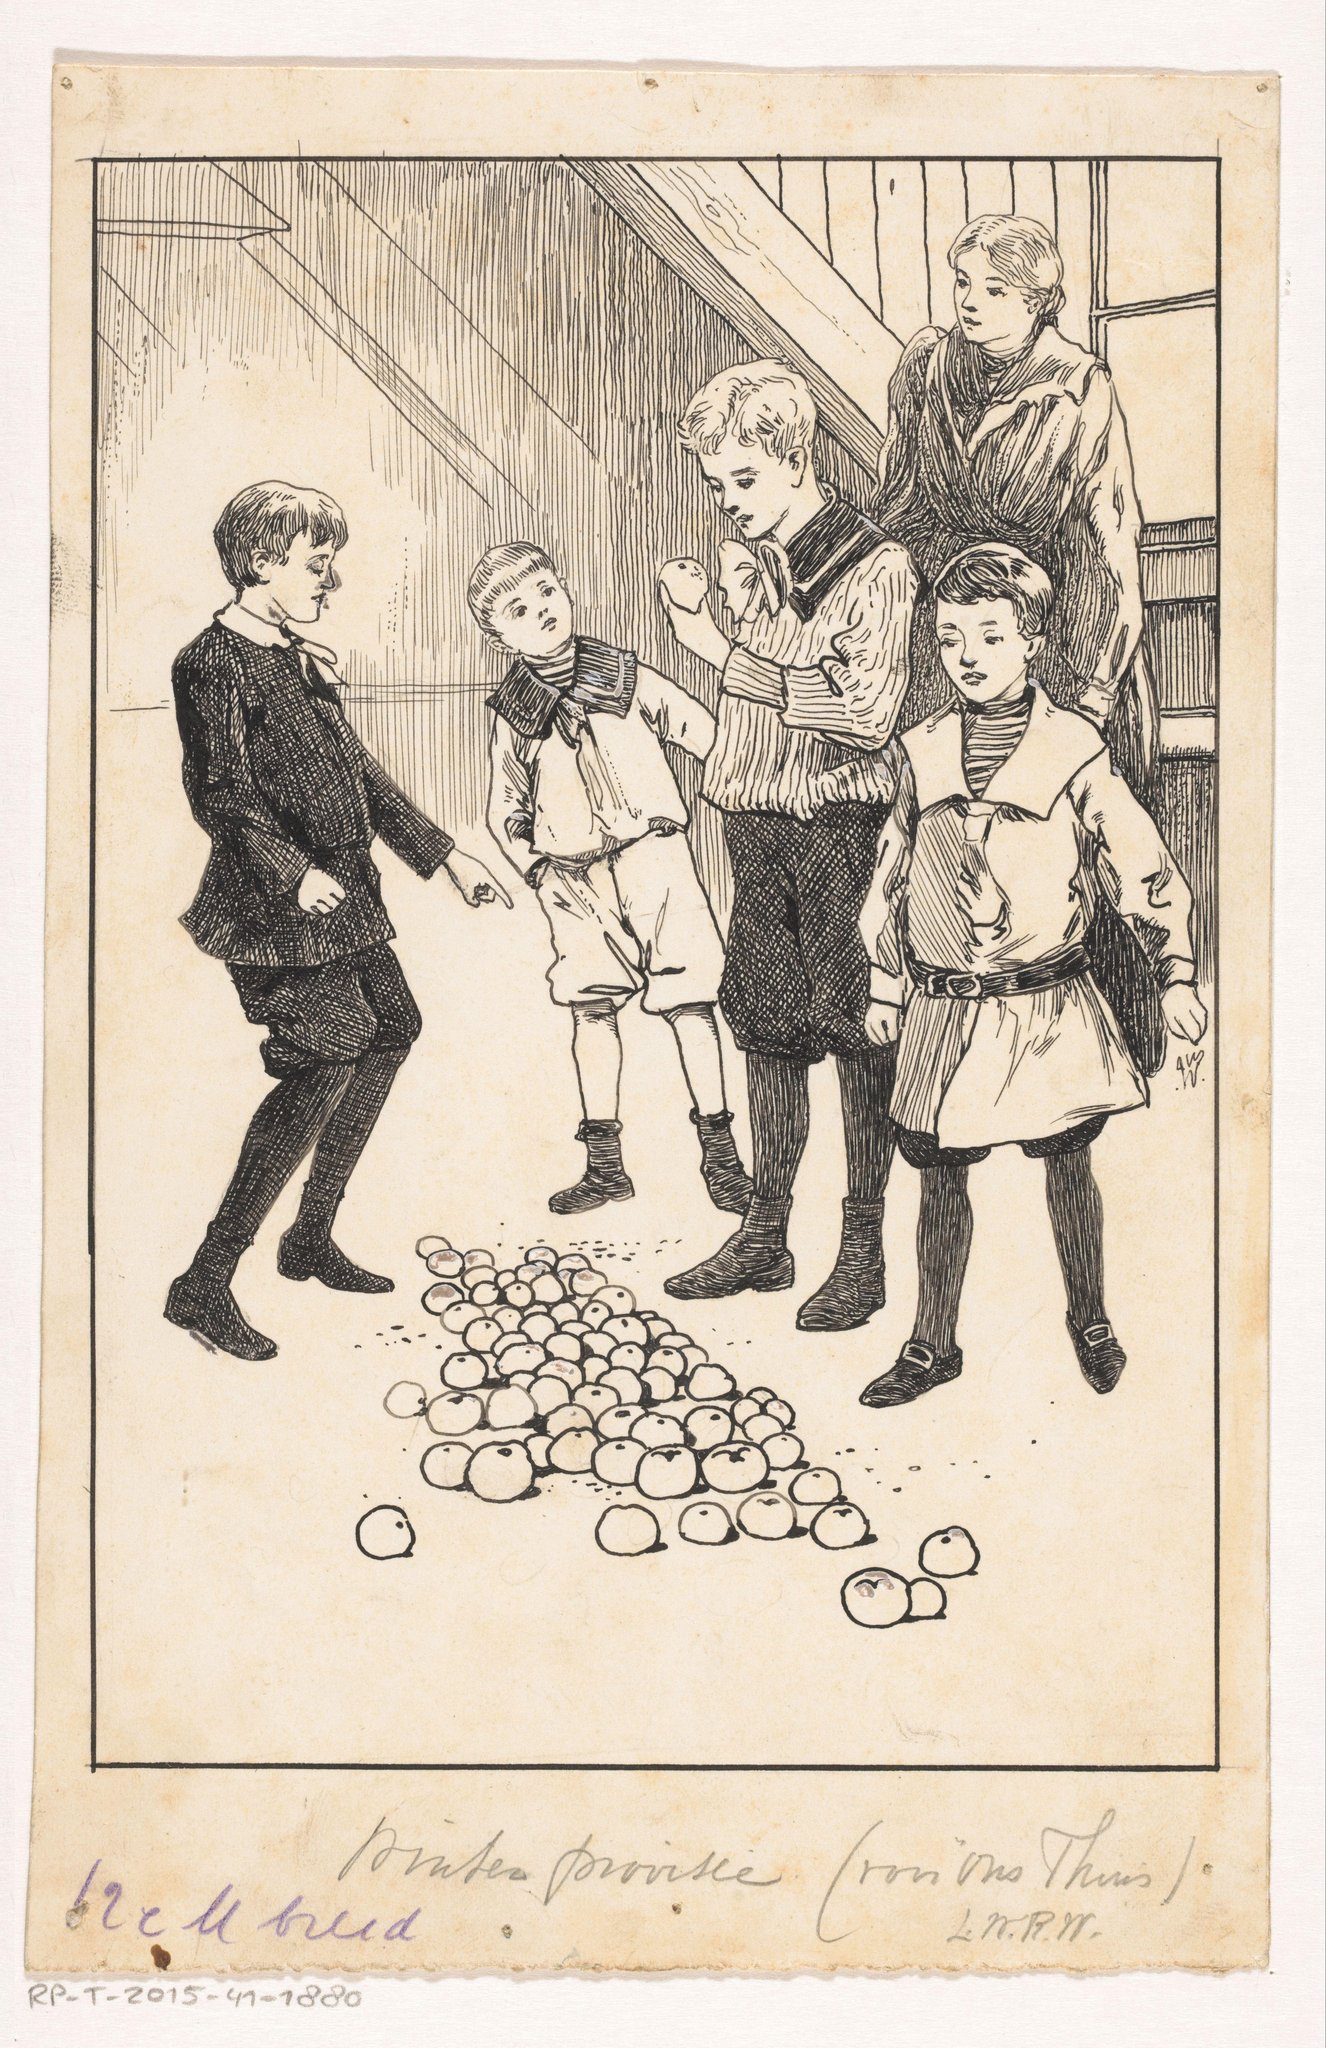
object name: drawing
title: Jongens bij een wintervoorraad appels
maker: willem wenckebach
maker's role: designer, draughtsman, painter, print maker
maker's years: 1860-1937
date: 1910-1937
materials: paint, ink, paper, pencil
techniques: brush, pen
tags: fruits: apple, boy (child between toddler and youth)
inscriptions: monogram:, collector's mark: Lugt 2228, :, annotation: ‘Winter provisie (voor Ons Thuis)/ L.W.R.W.’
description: Vier jongens staan bij een lading appels die op de grond ligt in een ruimte onder een trap. Eén van de jongens heeft een appel opgepakt en kijkt ernaar. In de achtergrond staat een vrouw in een winterjas.